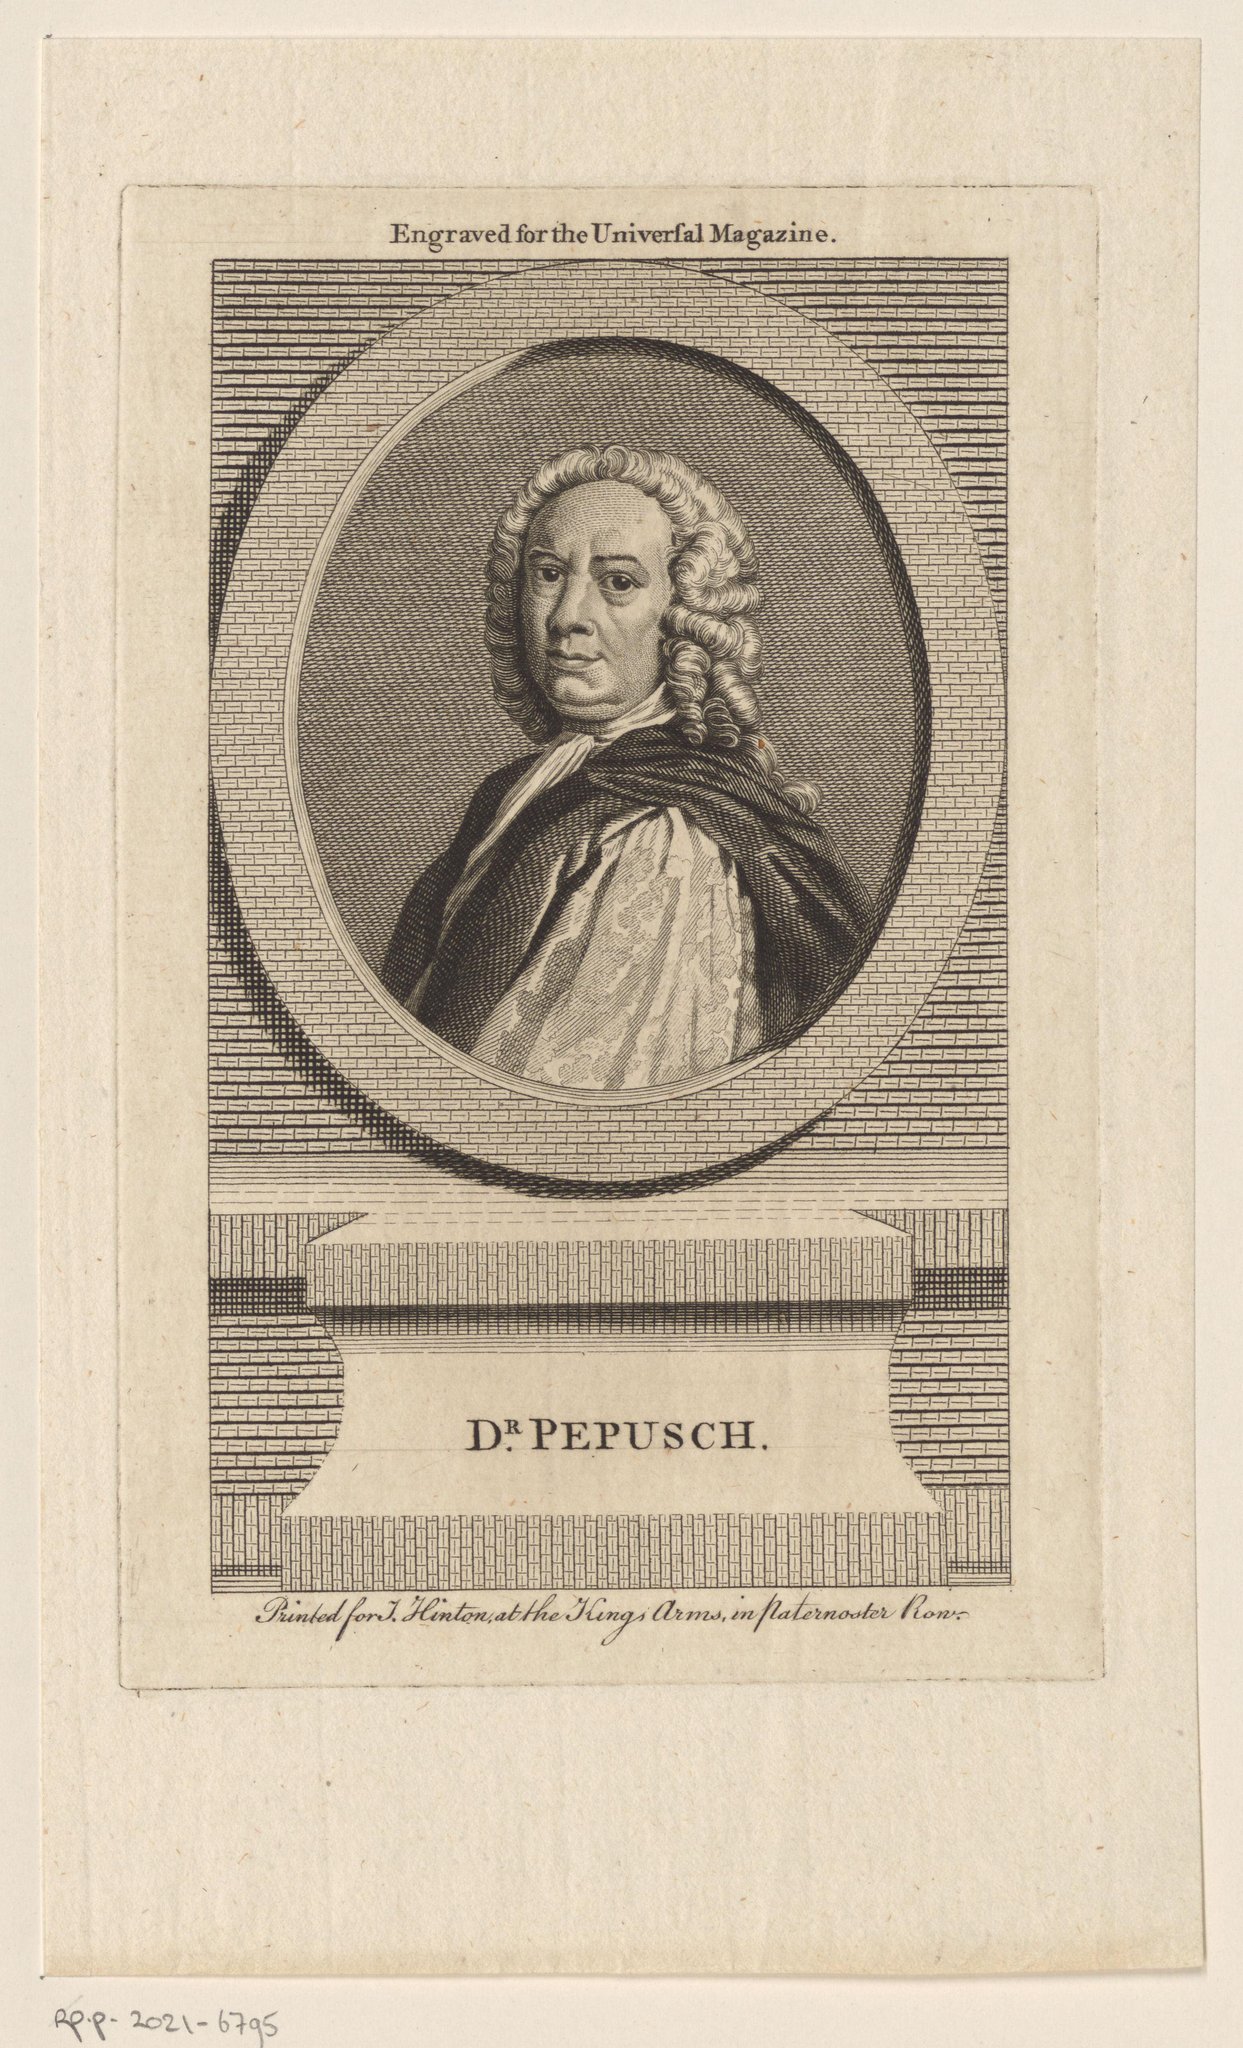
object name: print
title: Portret van John Christopher Pepusch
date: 1778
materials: paper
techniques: engraving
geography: london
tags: berlin, adult man, historical persons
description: Prent uit: The Universal Magazine of Knowledge and Pleasure 63 (1778), december 1778.